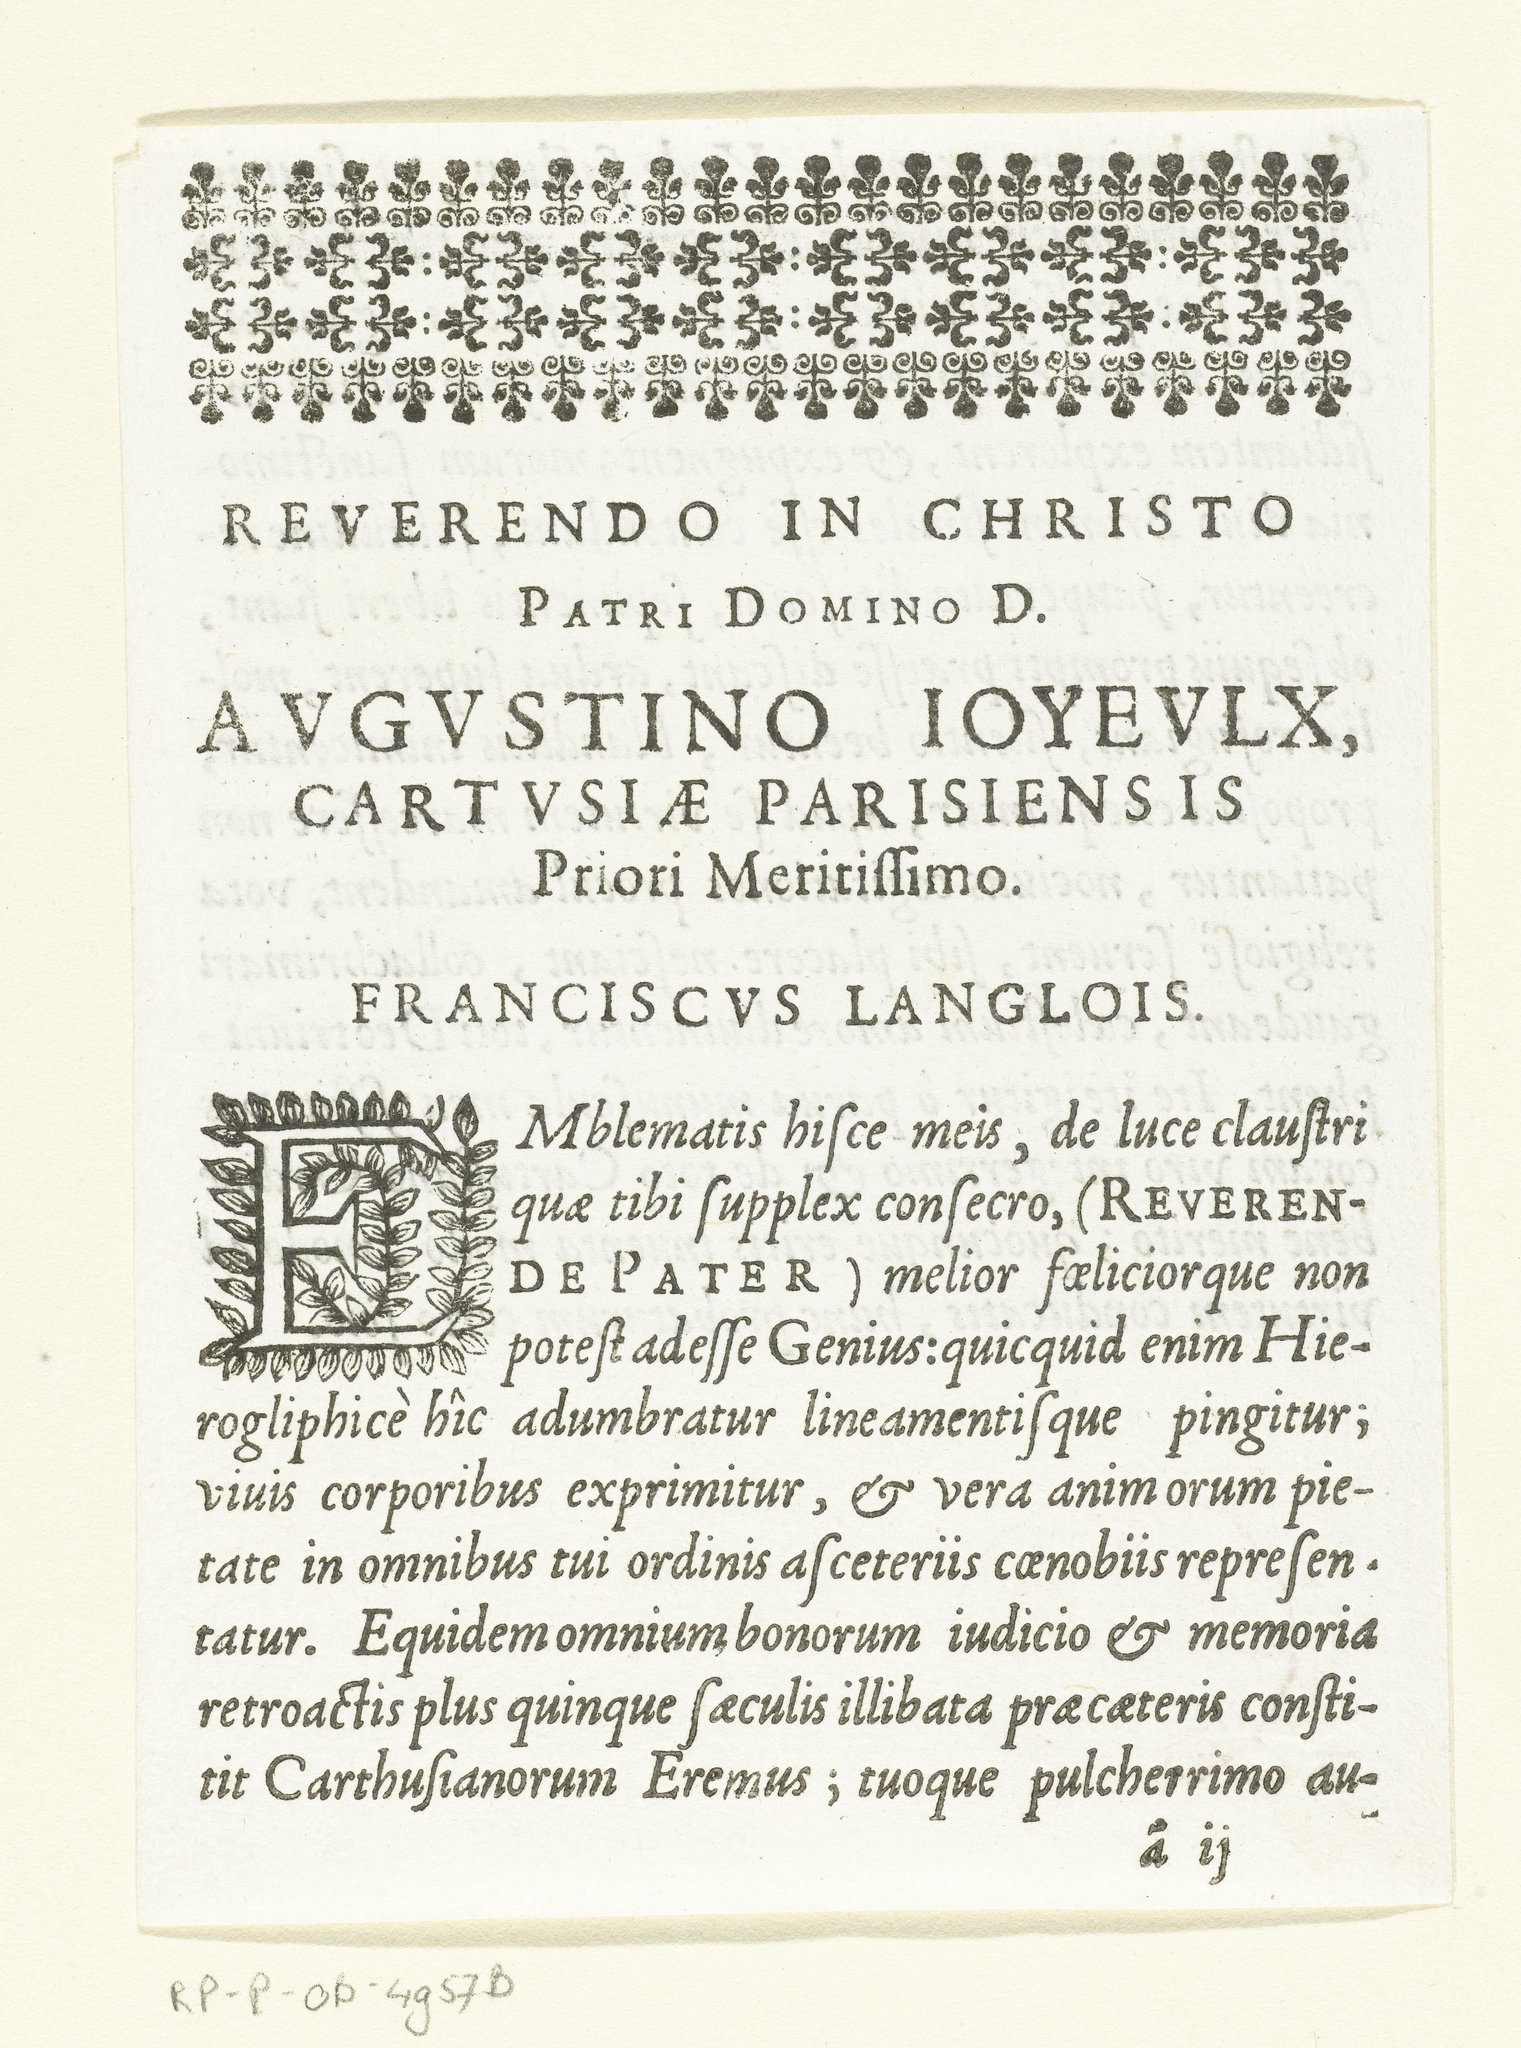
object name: text sheet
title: Ongeïllustreerde opdracht bij de embleemserie 'Kloosterleven in emblemen'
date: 1646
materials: paper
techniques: letterpress printing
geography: nancy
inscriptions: collector's mark: Lugt 240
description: Latijnse tekst in boekdruk. Dit blad (aan beide zijden bedrukt) bevat de opdracht aan een zekere geestelijke van de tweede staat van de embleemserie 'Kloosterleven in emblemen', die naast een ongeïllustreerde titelpagina en dit ongeïllustreerde blad met opdracht tevens een geïllustreerde titelpagina en 26 emblemen behelst.